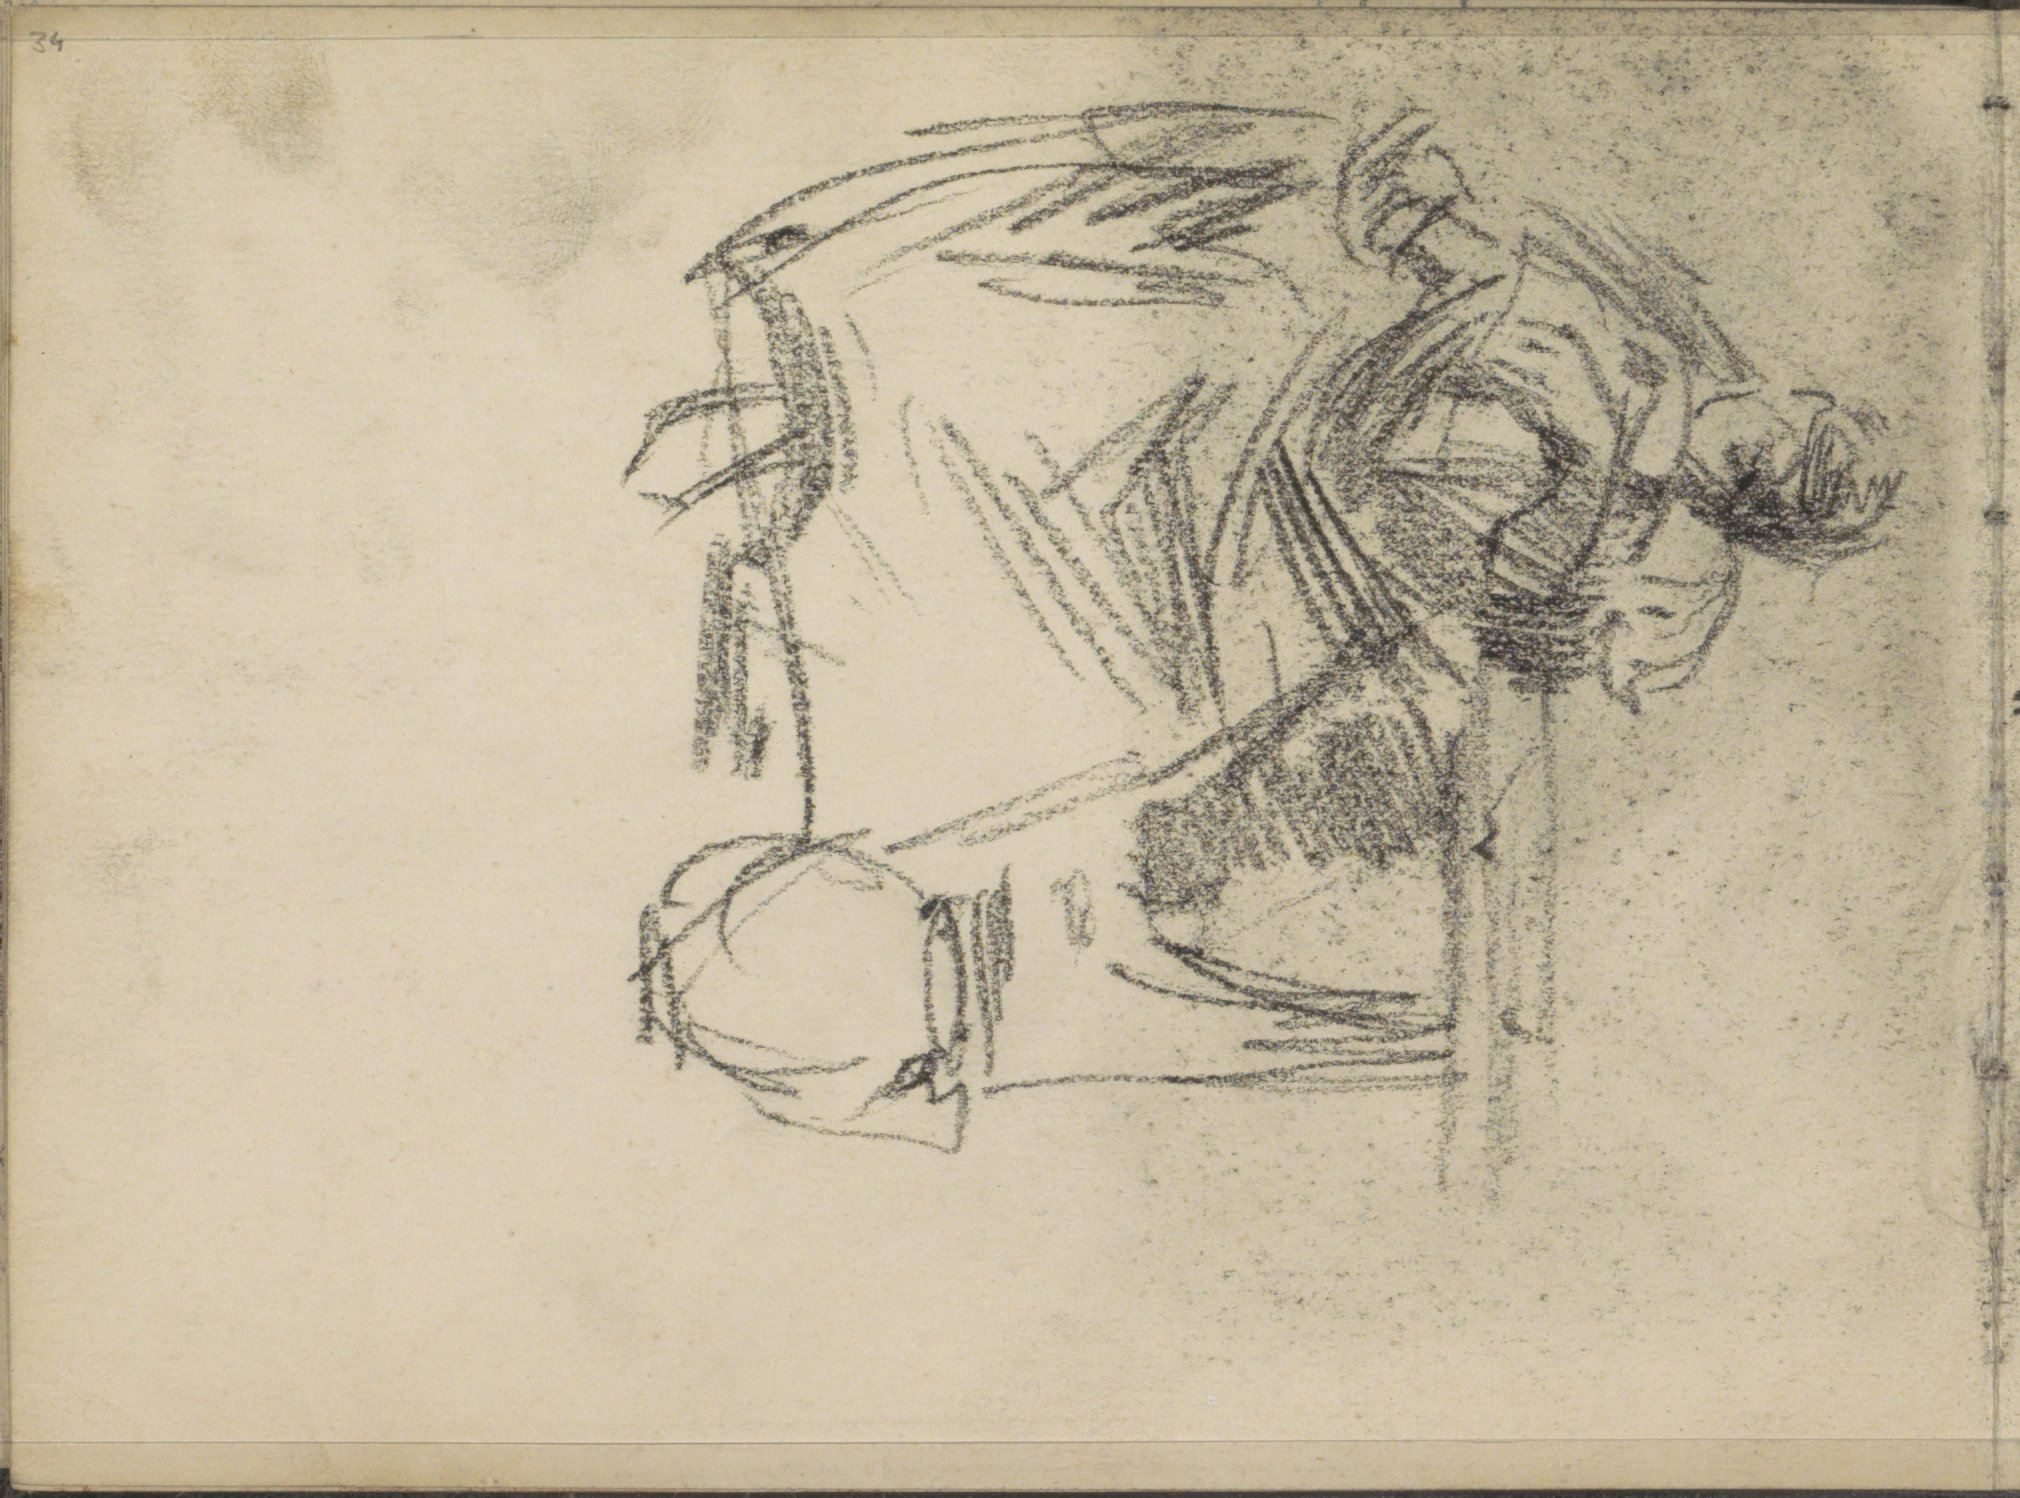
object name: sketchbook leaf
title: Zittende man bij een kruik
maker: marius bauer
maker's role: draughtsman, print maker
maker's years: 1867-1932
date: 1879-1884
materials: chalk, paper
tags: sitting figure, adult man, jar, jug (used as drinking-vessel)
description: De man heeft een kind of dier in de armen. Pagina 34 uit een schetsboek met 28 bladen.